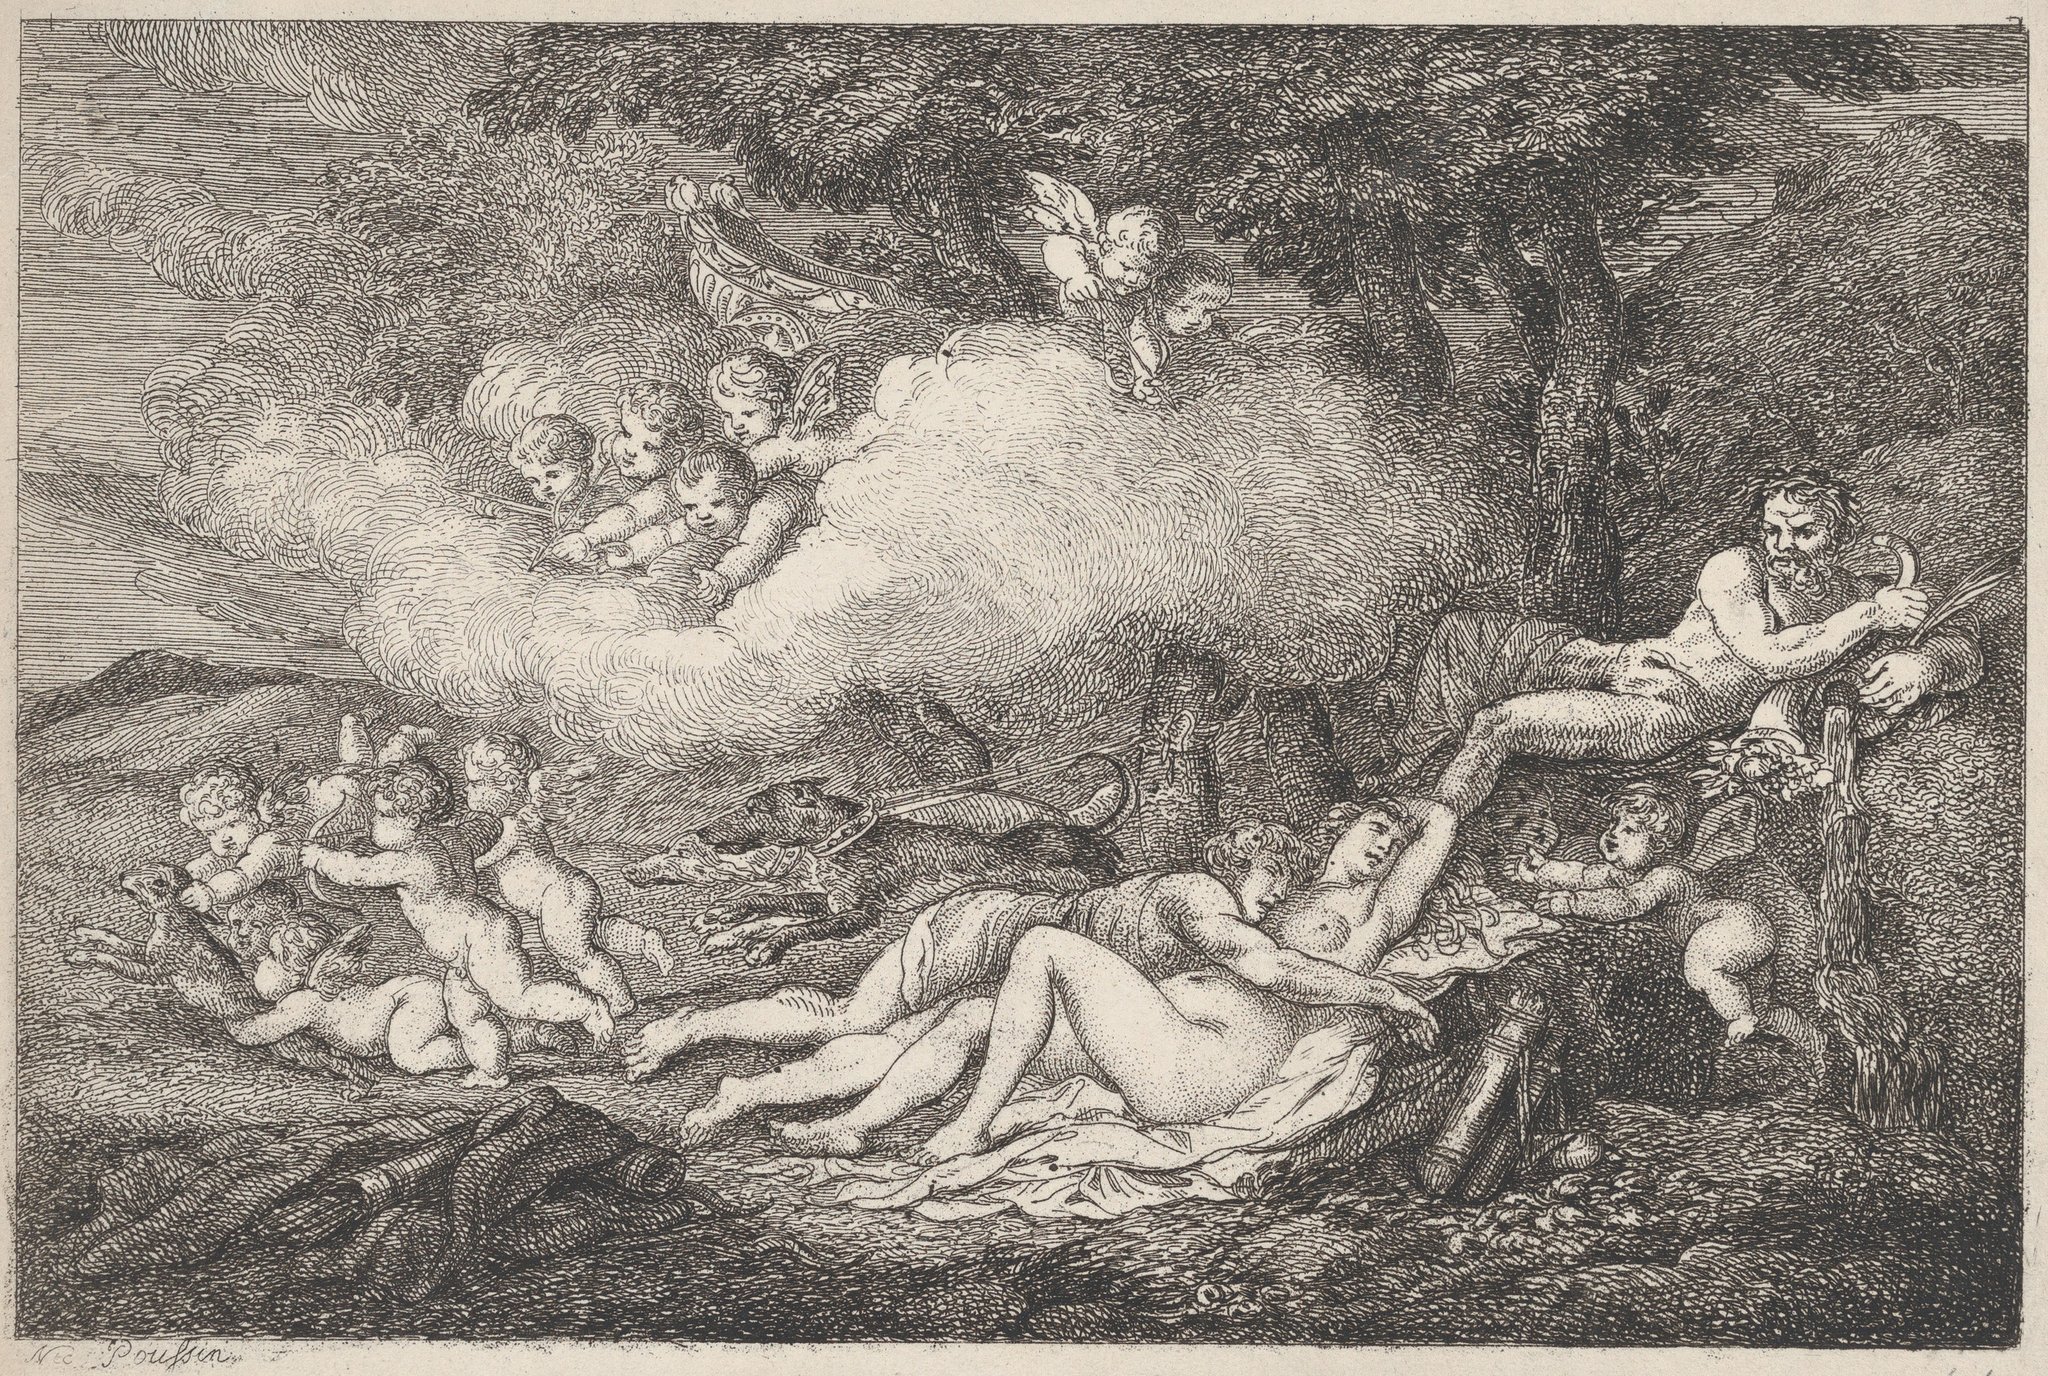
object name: print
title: Mars and Sleeping Venus with Putti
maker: thomas rowlandson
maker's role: artist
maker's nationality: british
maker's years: 1757-1827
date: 1799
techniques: etching